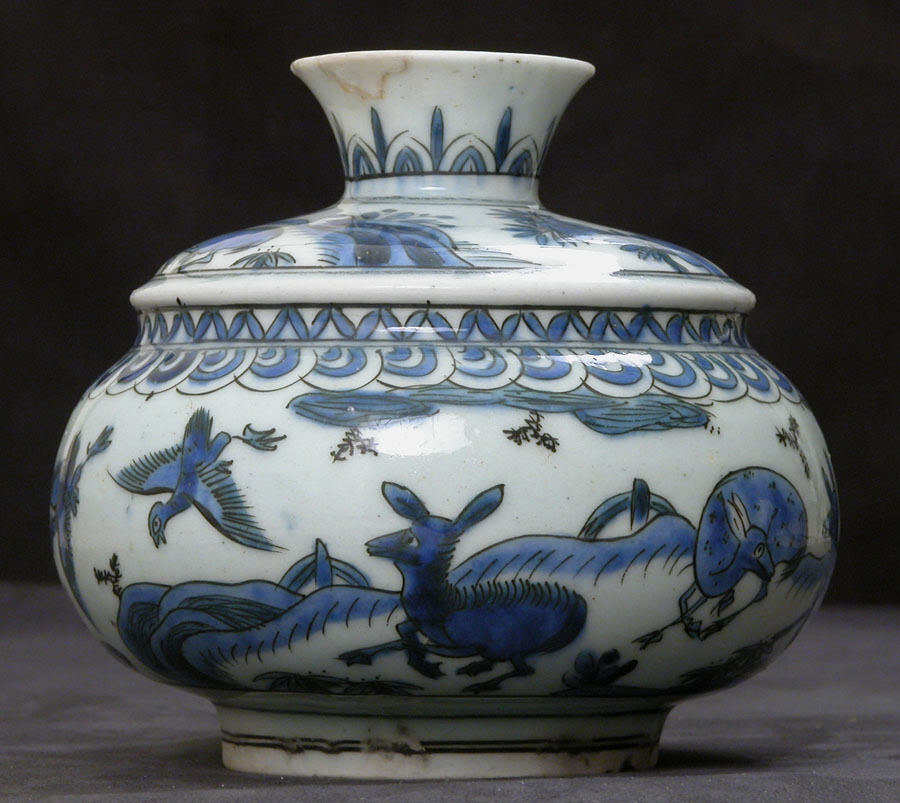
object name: vase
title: Vase with Animals in a Landscape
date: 1601-1700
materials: glaze, stonepaste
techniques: painting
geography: iran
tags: animals,birds